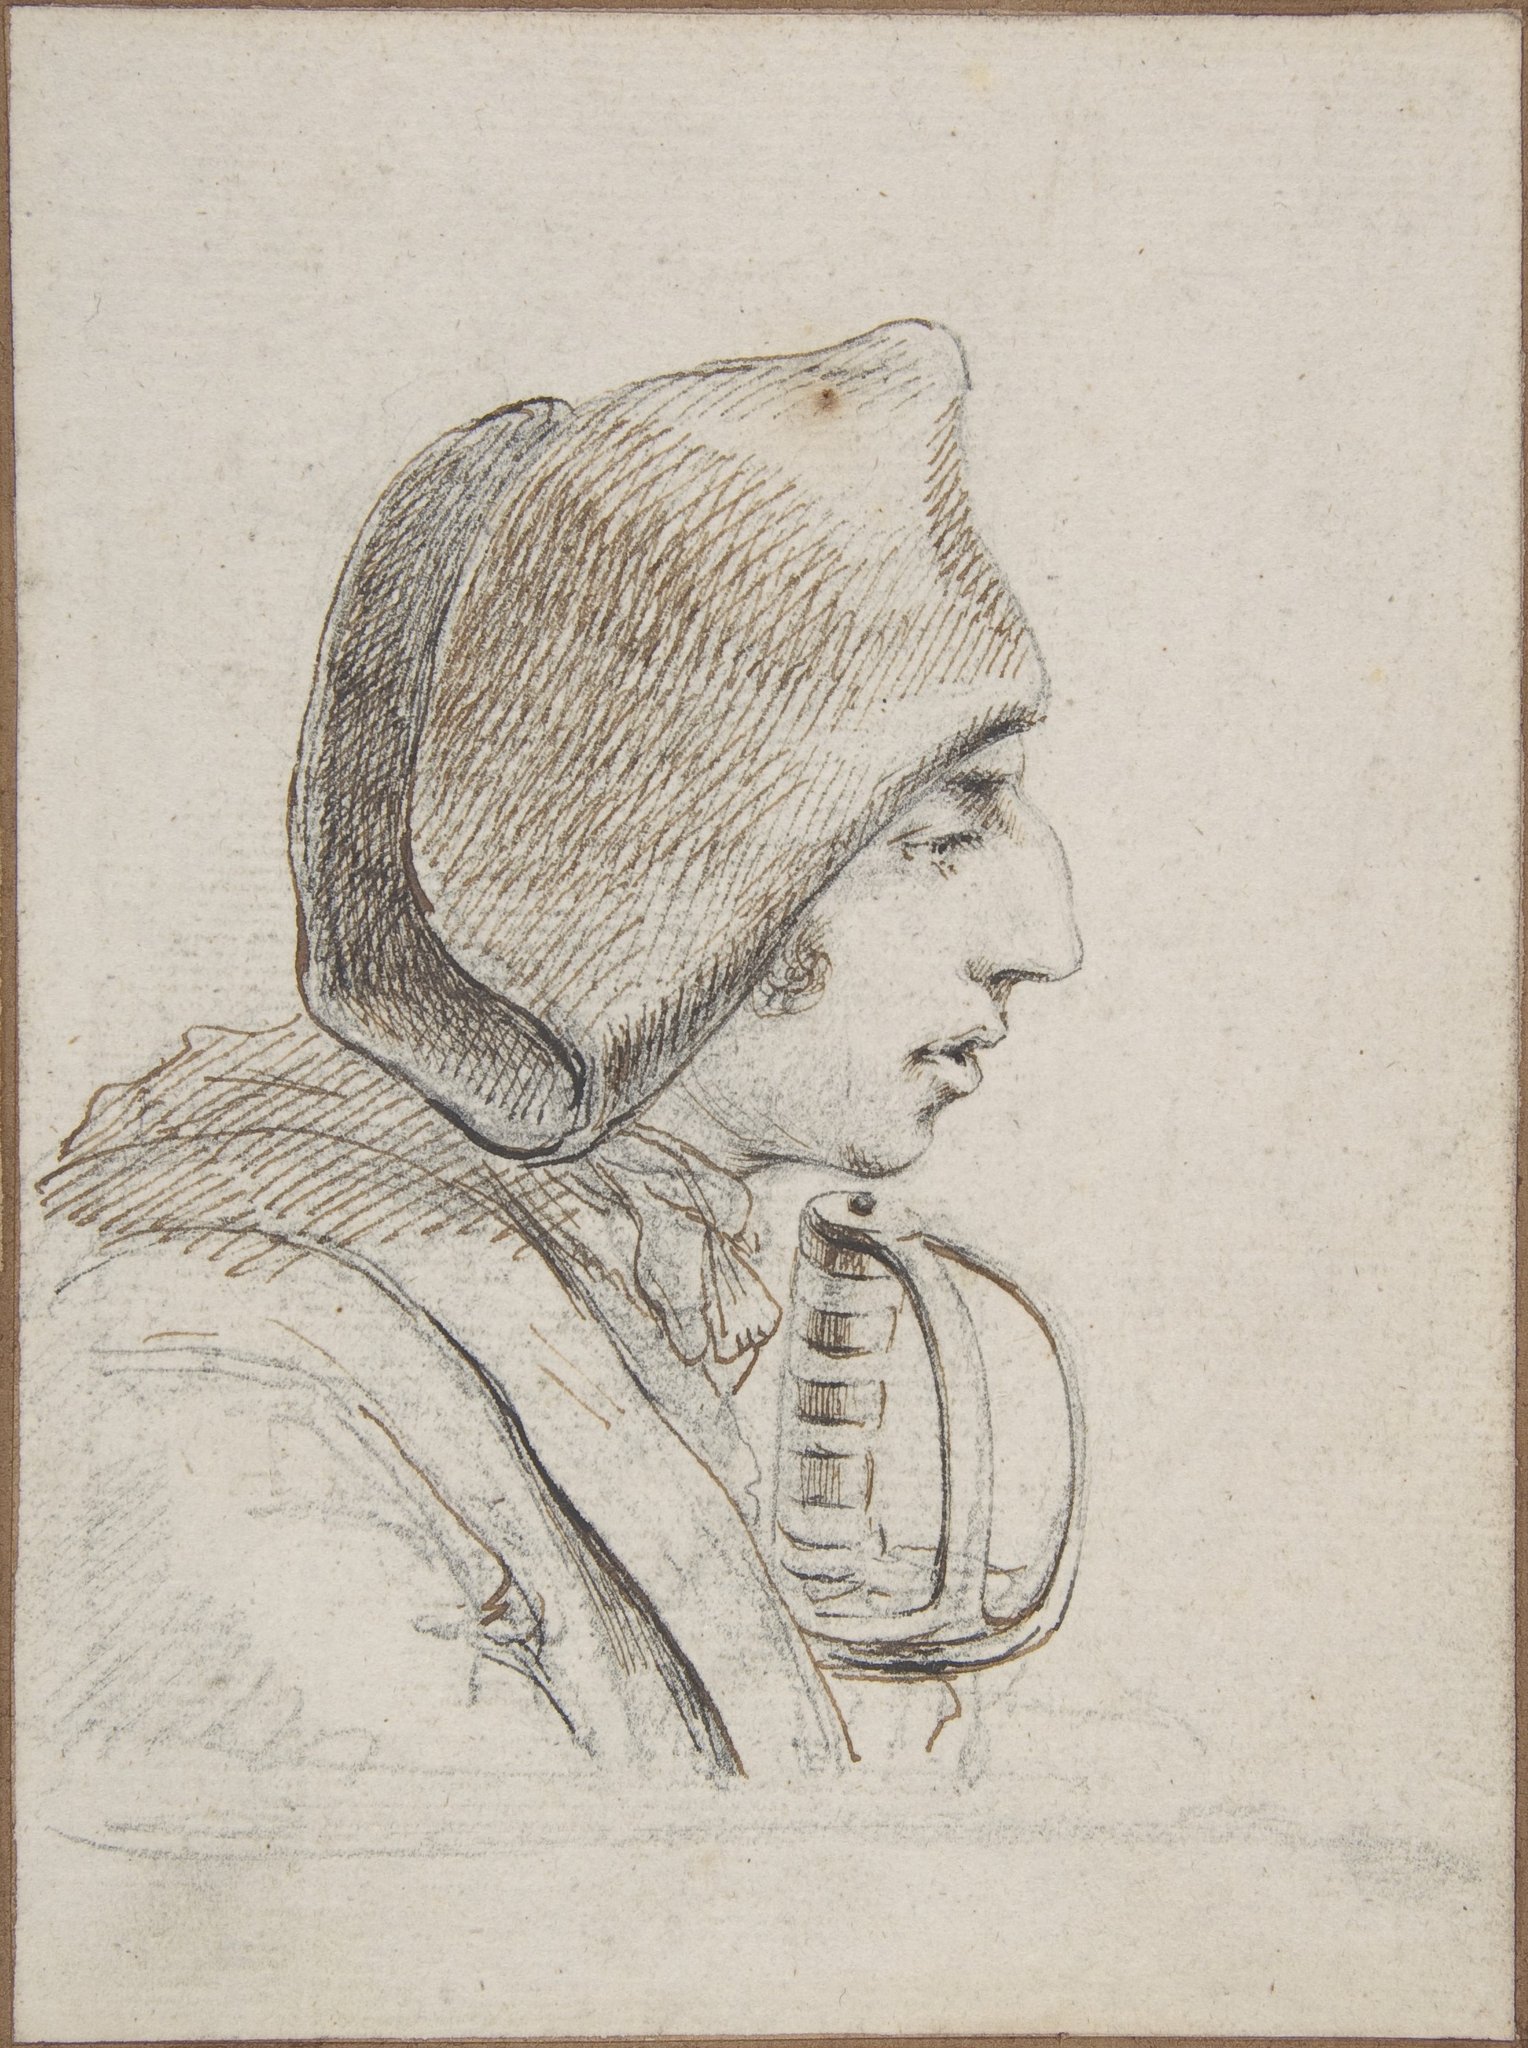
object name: drawing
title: Head of a soldier in profile, with a sword handle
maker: baron dominique vivant denon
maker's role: artist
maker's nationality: french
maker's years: 1747-1825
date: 1794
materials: chalk, ink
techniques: pen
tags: soldiers,hilts,men,profiles